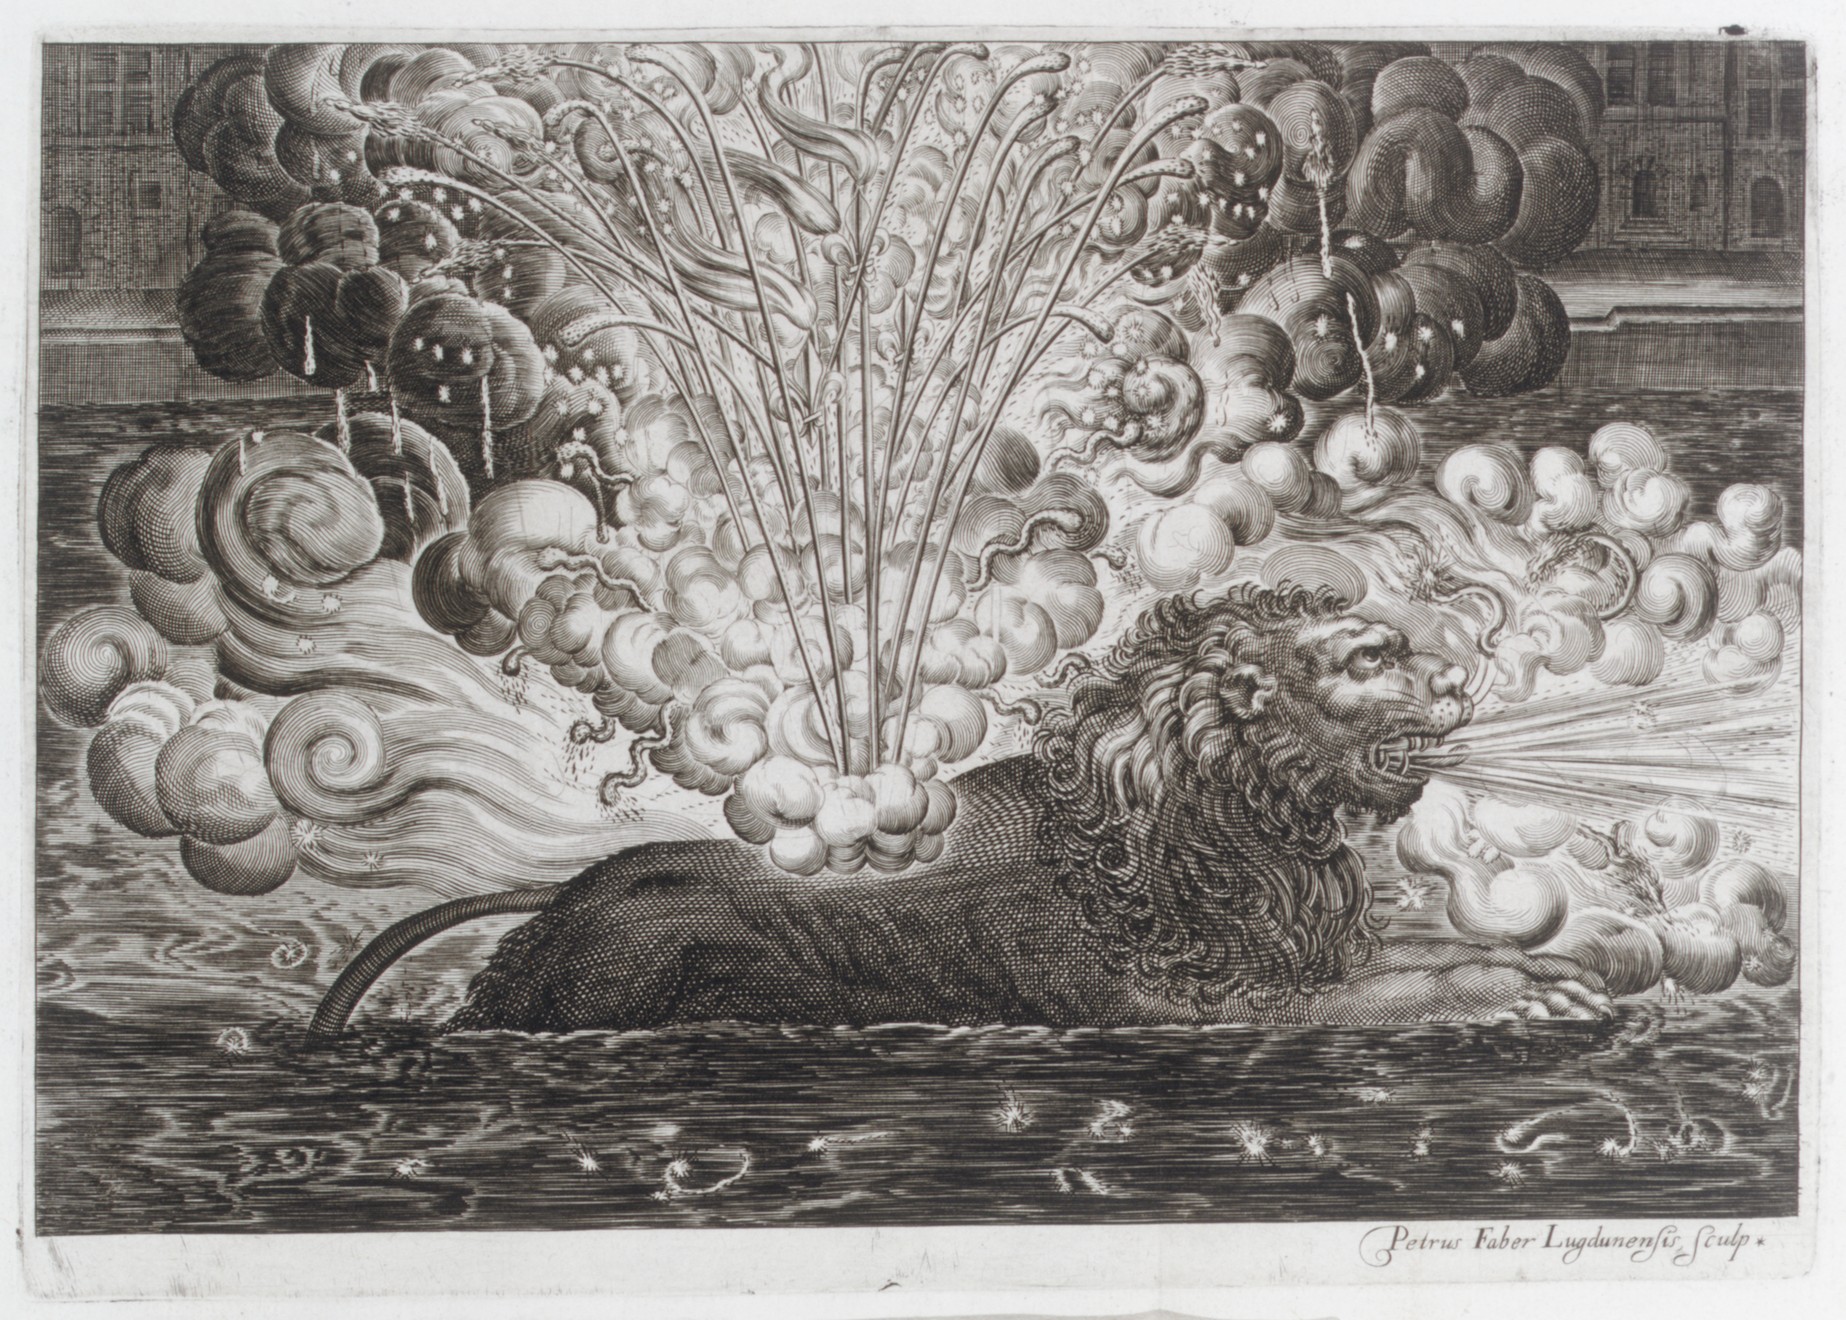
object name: book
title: Le Soleil Au Signe du Lyon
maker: jacques roussin, lyon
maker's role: publisher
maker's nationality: french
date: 1623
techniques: cutting, printing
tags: lions